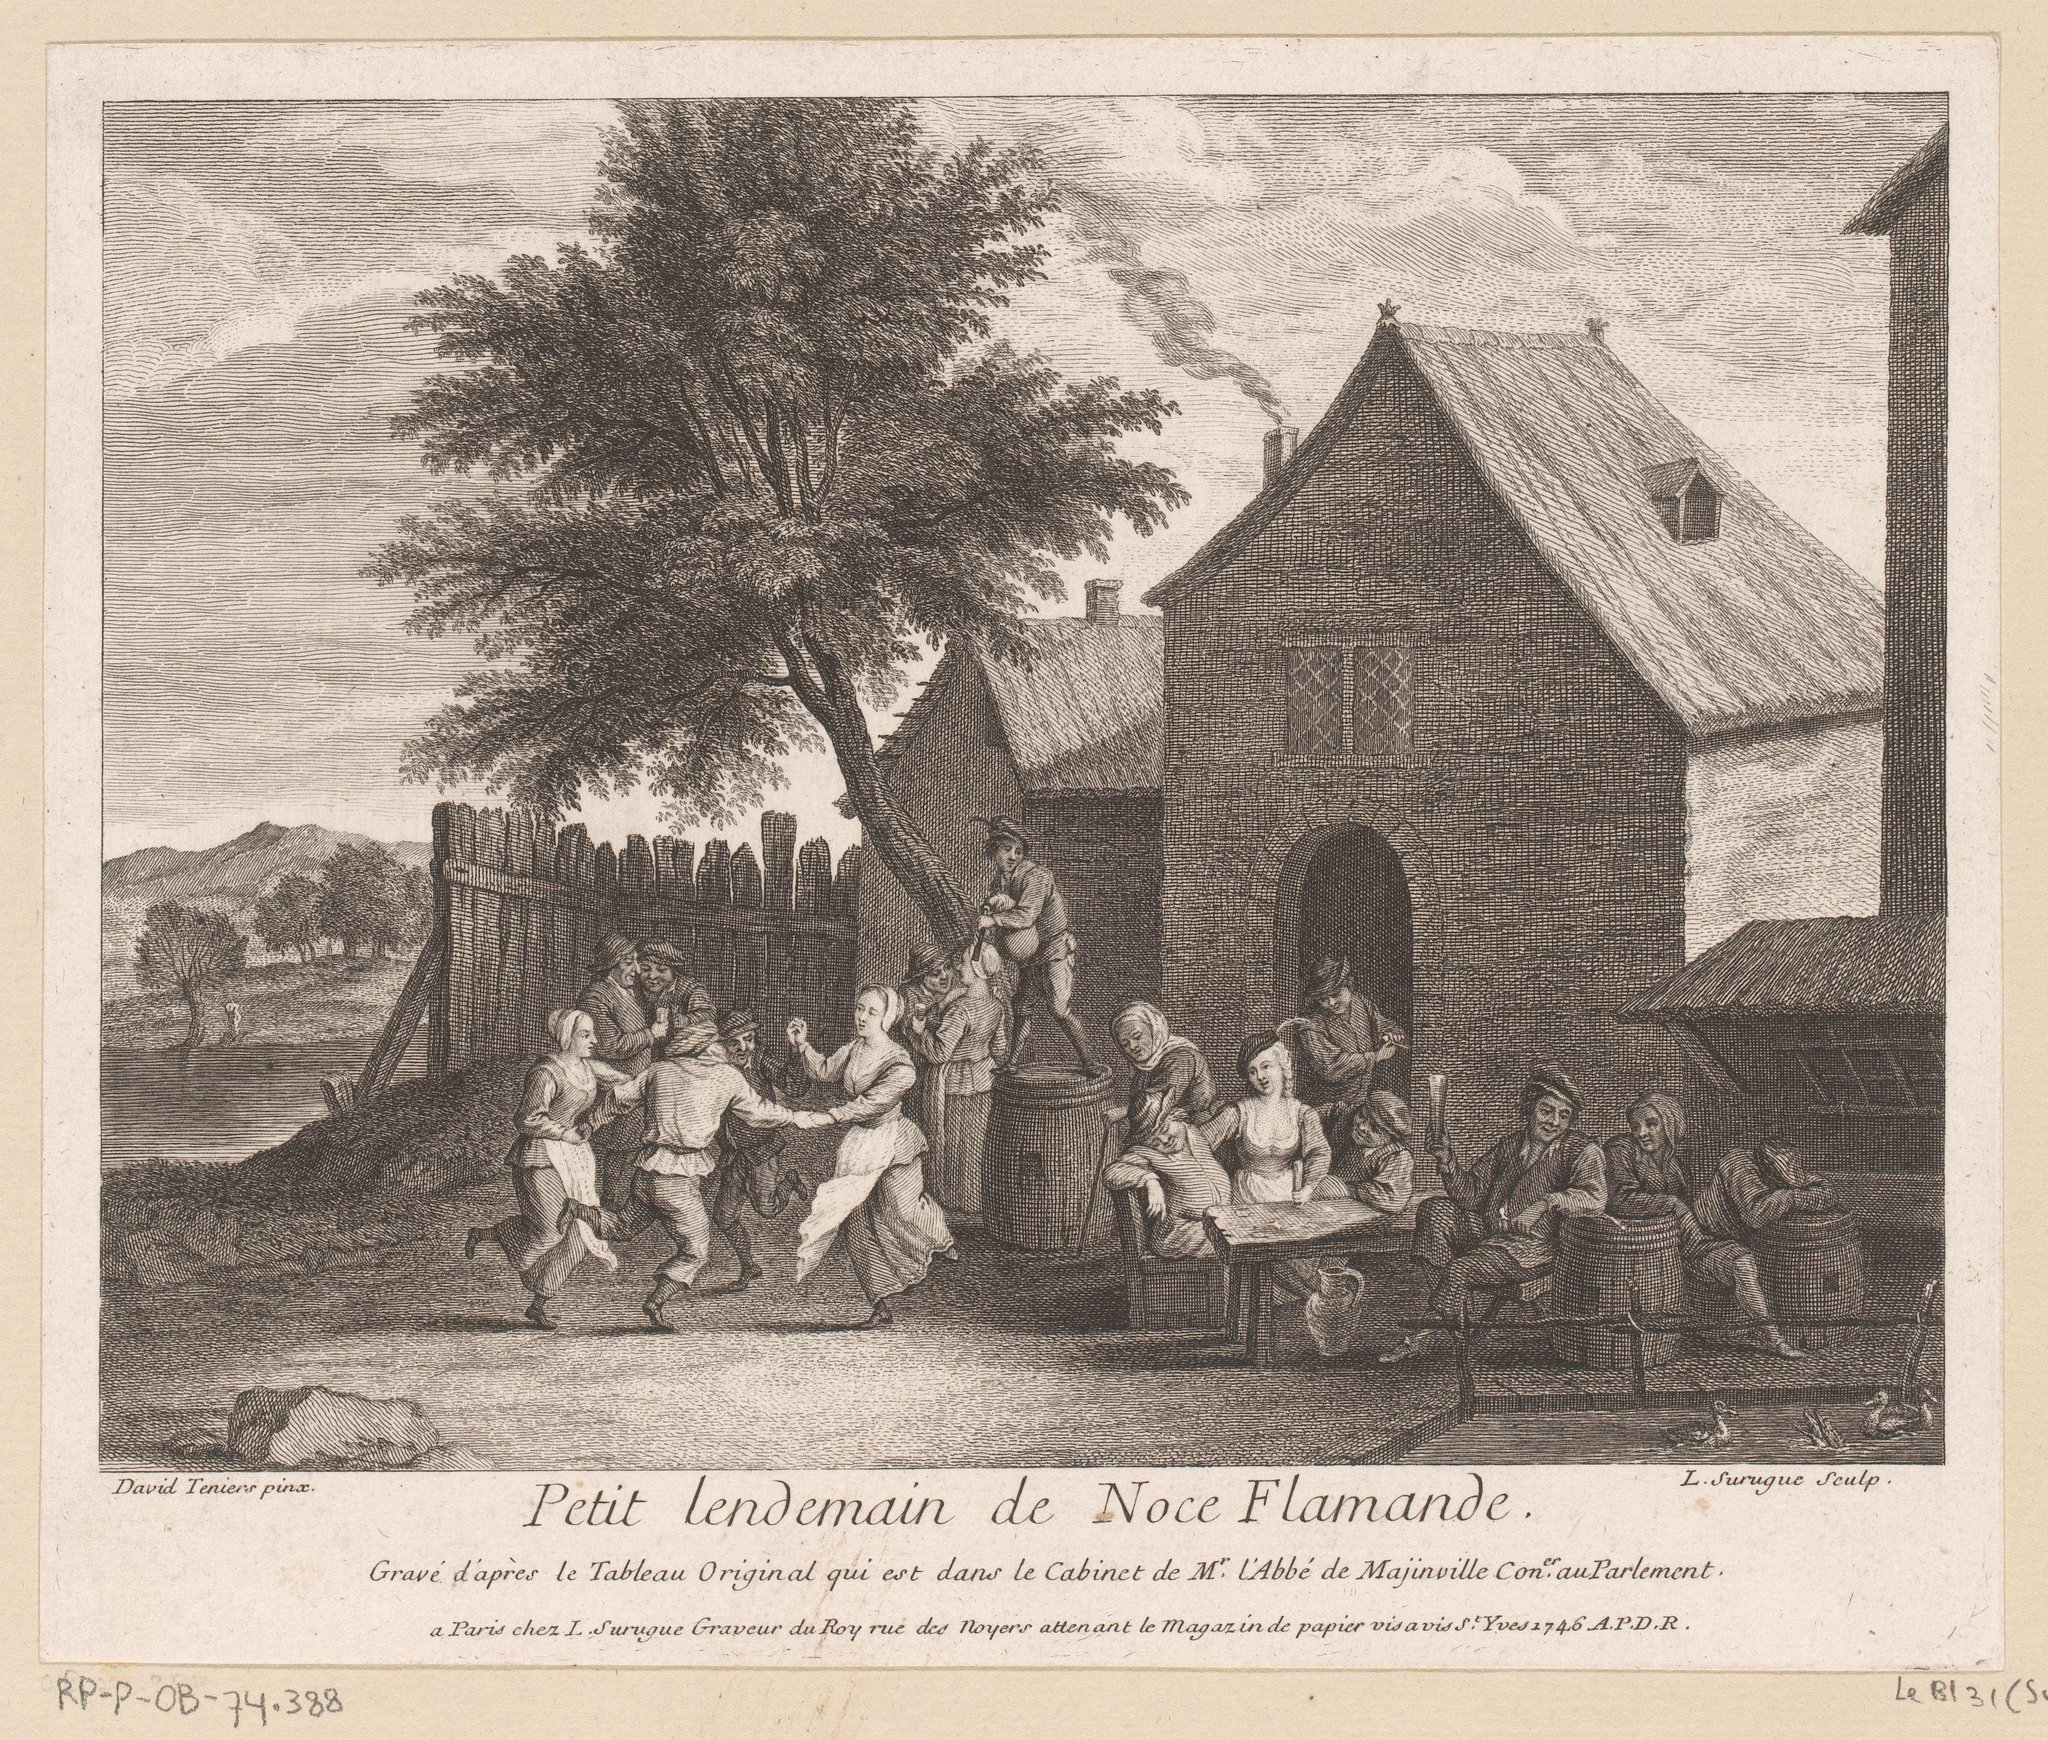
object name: print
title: Petit lendemain de noce Flamande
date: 1746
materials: paper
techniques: engraving, etching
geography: paris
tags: village, group dancing, hotel, hostelry, inn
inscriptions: collector's mark: Lugt 240